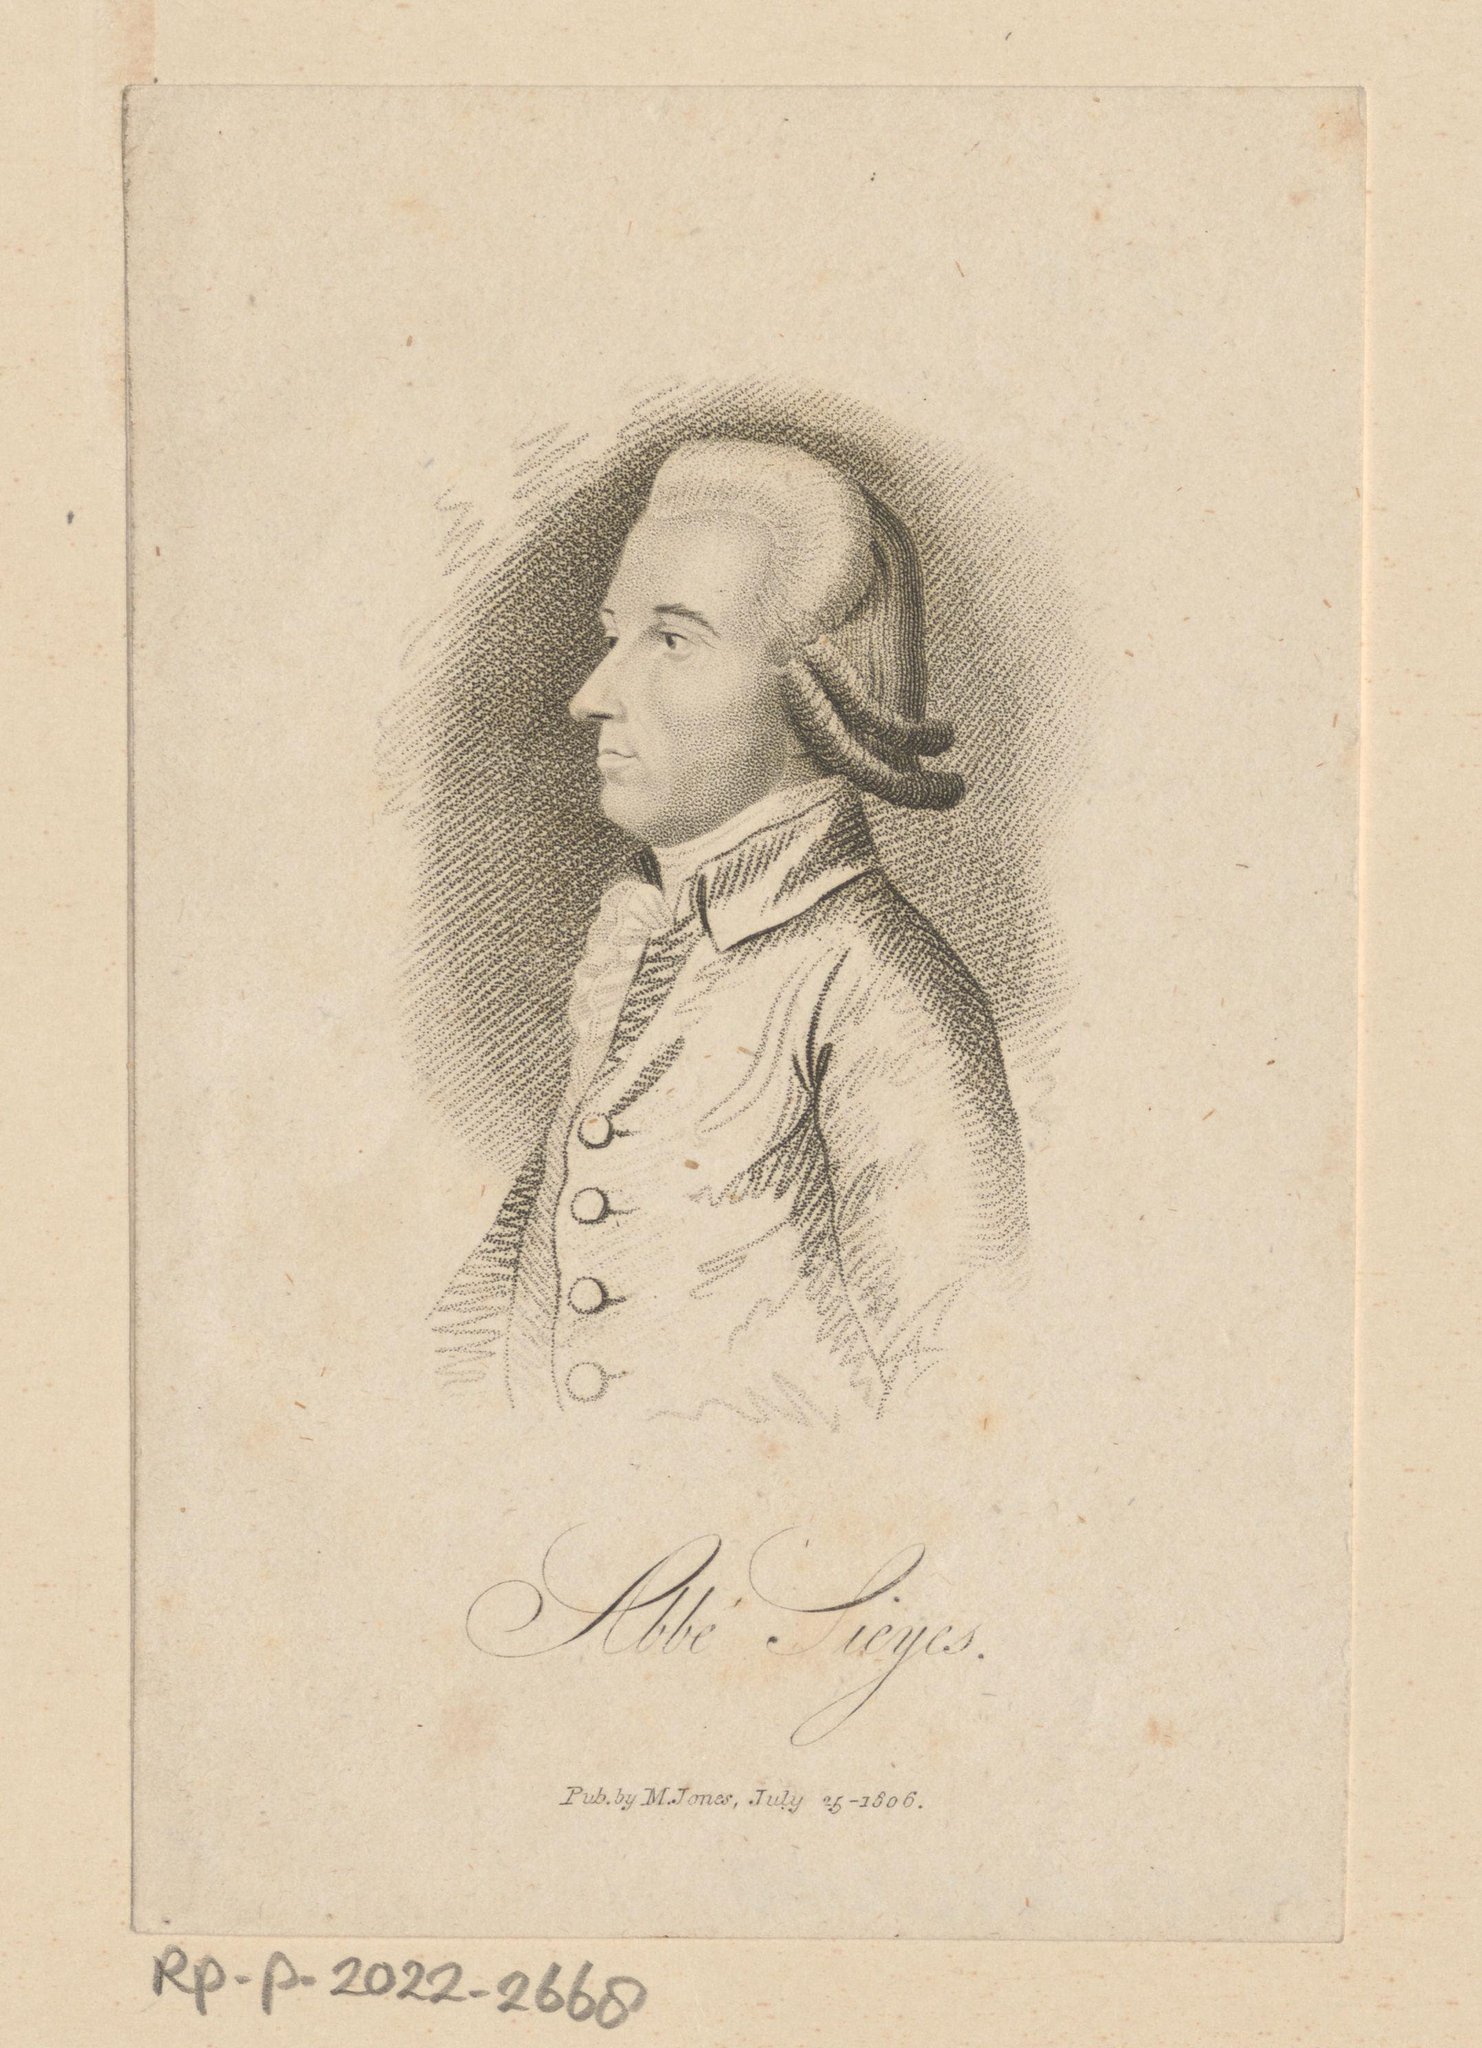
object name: print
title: Portret van Emmanuel Joseph Sieyès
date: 1806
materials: paper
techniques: roulette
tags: politician, historical persons, politician, e.g. party leader